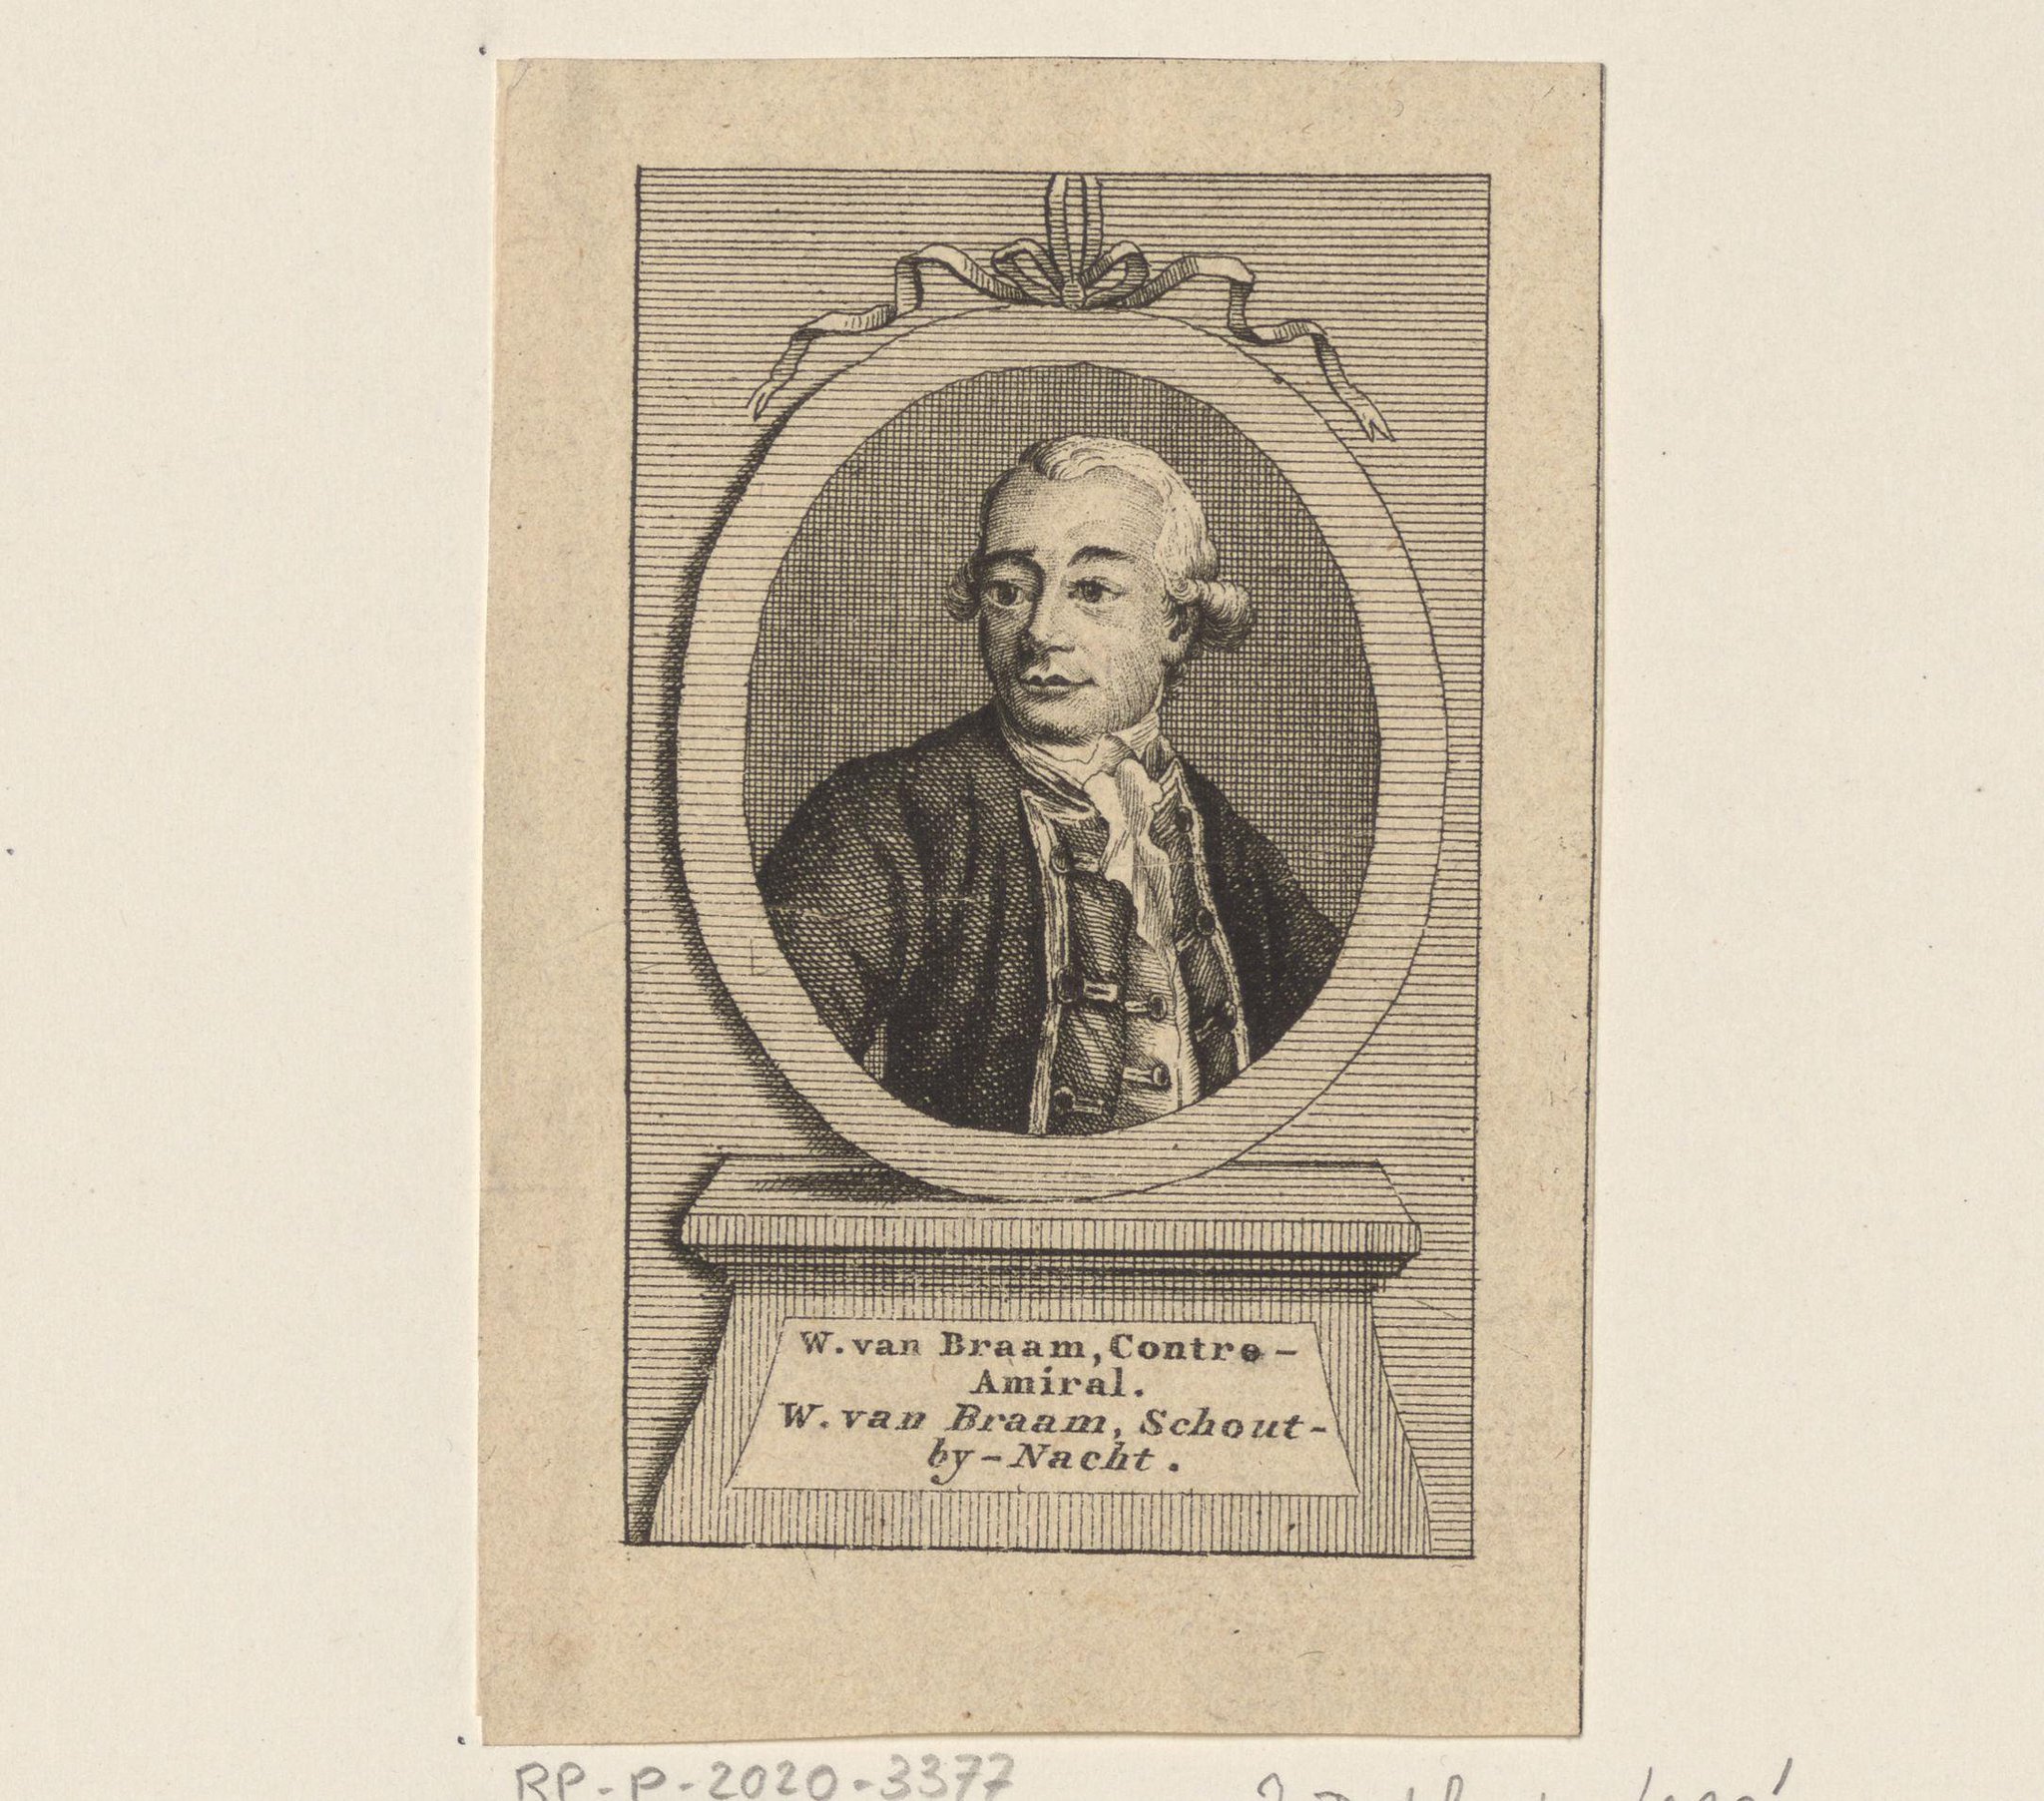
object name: print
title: Portret van Willem van Braam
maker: Anonymous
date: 1780-1799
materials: paper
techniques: engraving, etching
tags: historical persons, commander-in-chief, admiral